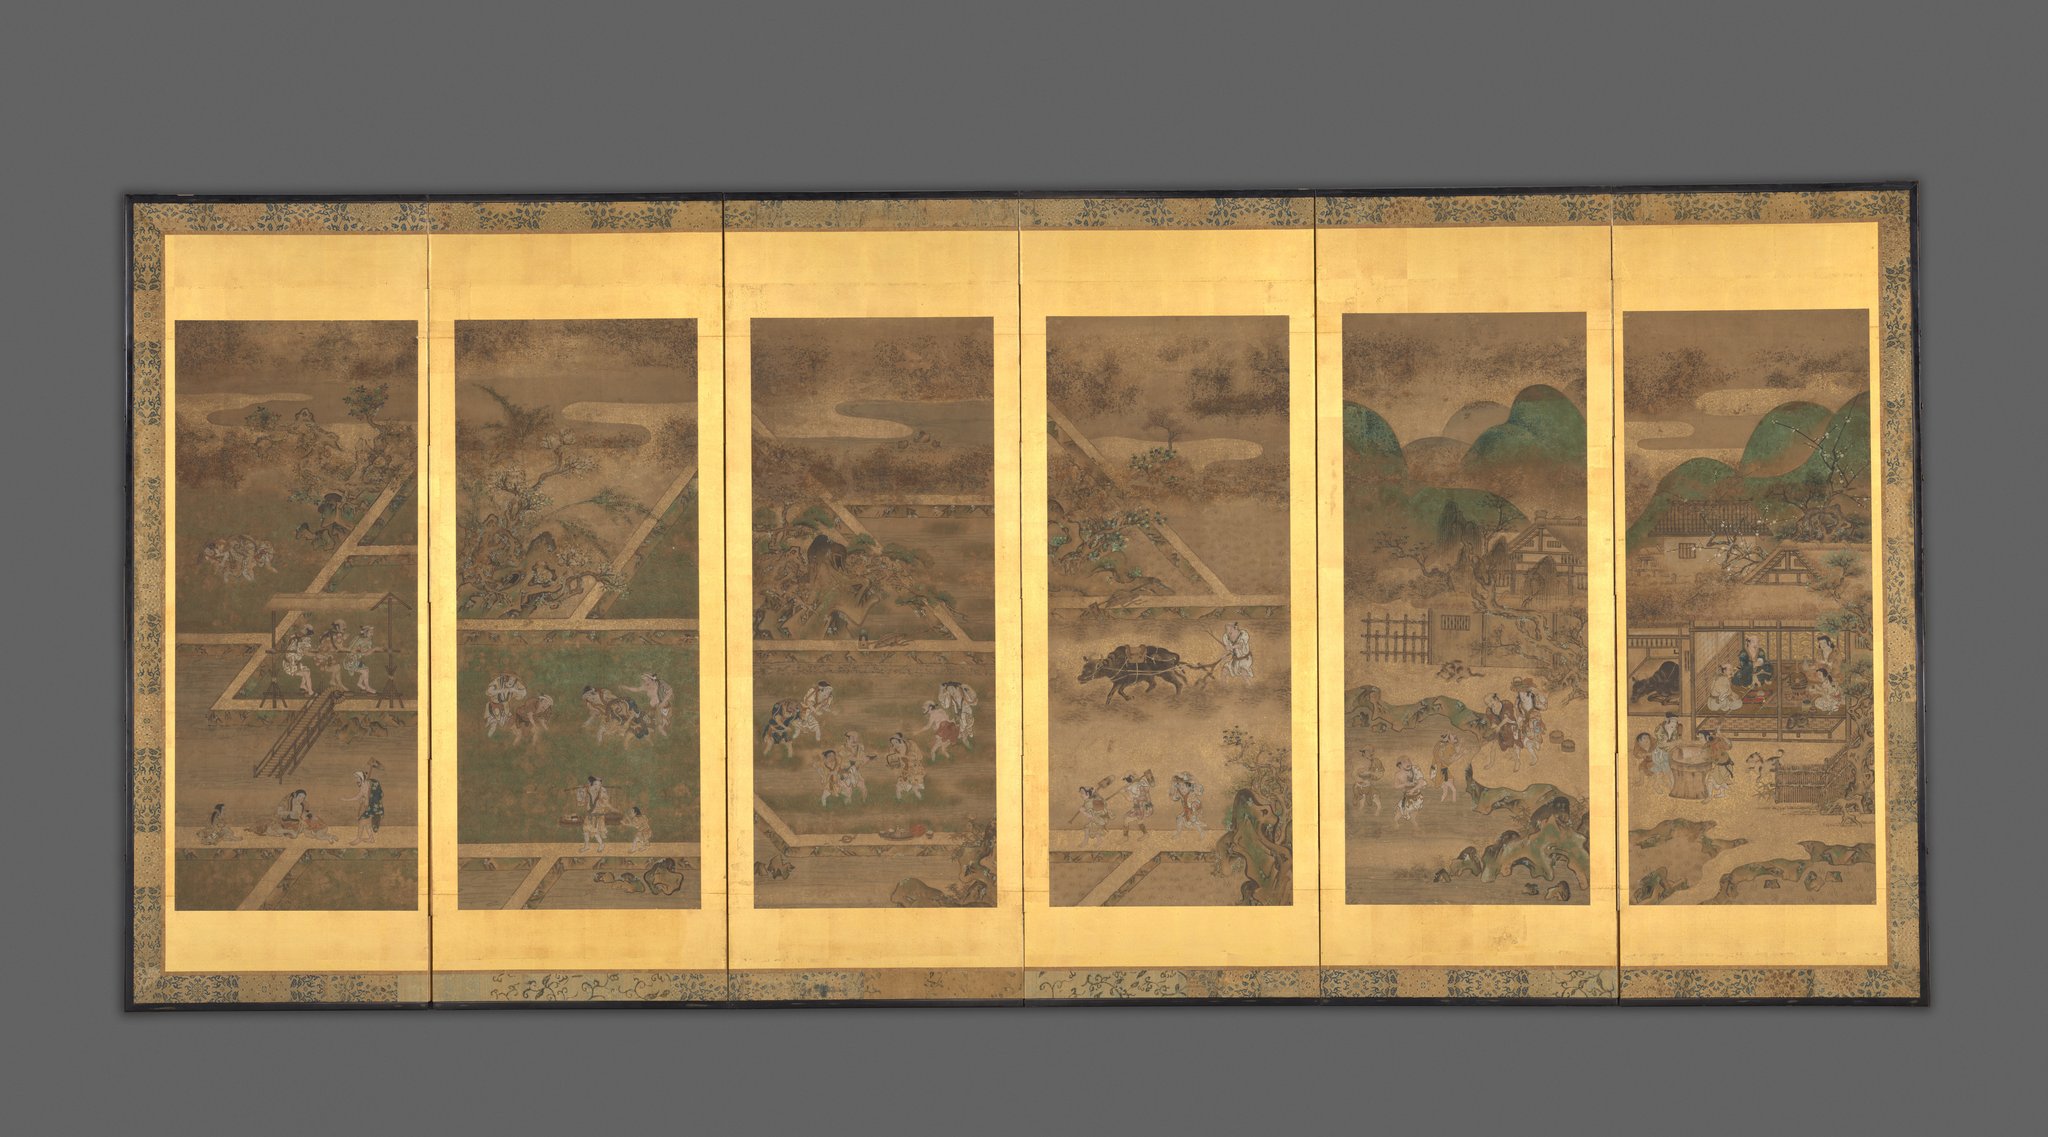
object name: screen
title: Farmers' Lives in the Twelve Months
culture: japanese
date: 1667-1733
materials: ink, panel, paper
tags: animals,working,farmers